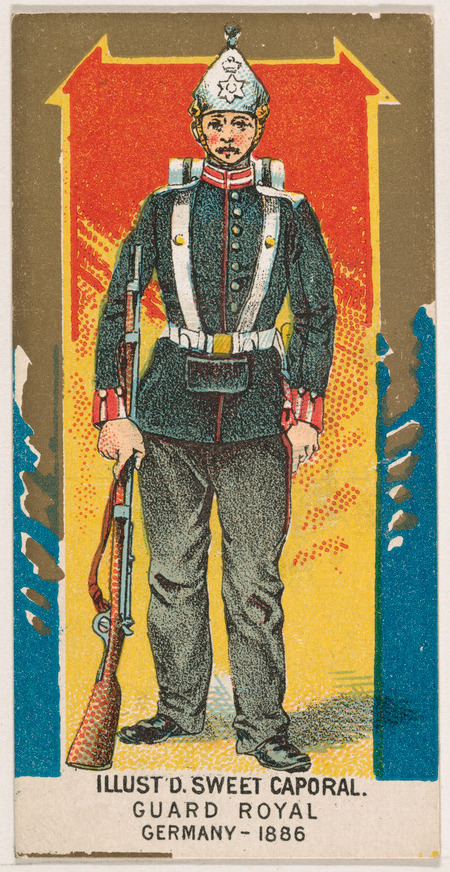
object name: print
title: Royal Guard, Germany, 1886, from the Military Series (N224) issued by Kinney Tobacco Company to promote Sweet Caporal Cigarettes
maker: kinney brothers tobacco company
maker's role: publisher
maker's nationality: american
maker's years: 1869-2011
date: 1888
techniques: color lithograph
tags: military,firearms,men